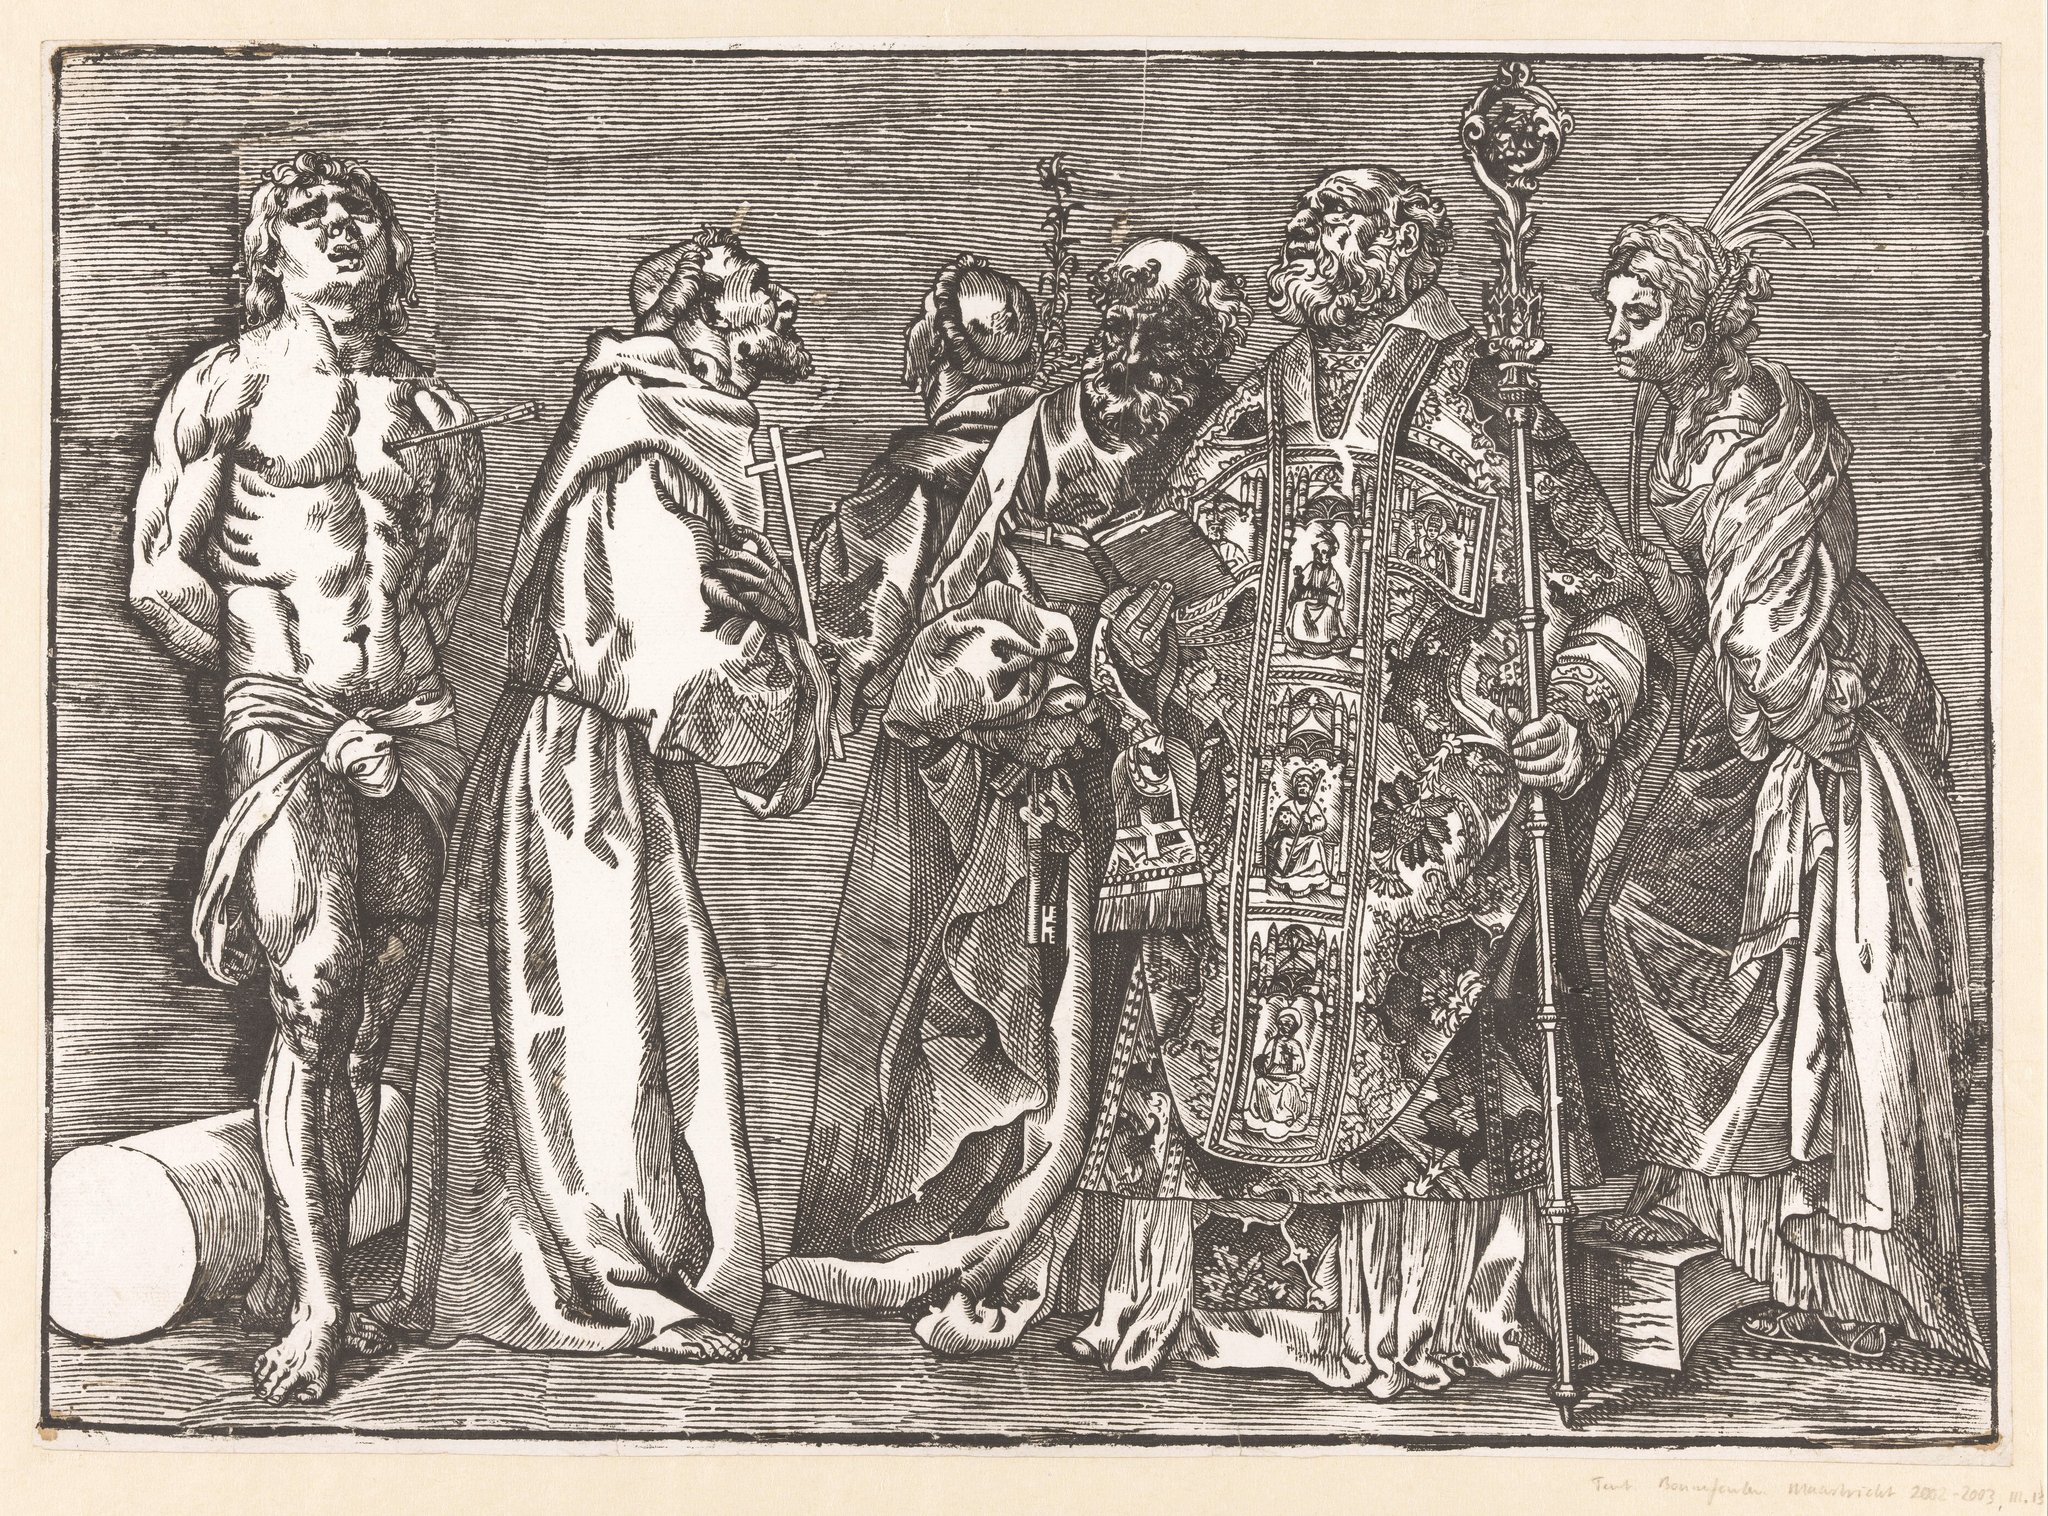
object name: print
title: Zes staande heiligen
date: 1535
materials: paper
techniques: woodcut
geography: venice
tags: the virgin martyr catherine of alexandria; possible attributes: book, crown, emperor maxentius, palm-branch, ring, sword, wheel, the bishop nicholas of myra (or bari); possible attributes: anchor, boat, three golden balls (on a book), three purses, three children in a tub, three maidens, the martyr sebastian; possible attributes: arrow(s), bow, tree-trunk, founder of the order of friars minor (franciscans), francis(cus) of assisi; possible attributes: book, crucifix, lily, skull, stigmata, the apostle peter, first bishop of rome; possible attributes: book, cock, (upturned) cross, (triple) crozier, fish, key, scroll, ship, tiara, the franciscan monk antony of padua; possible attributes: ass, book, crucifix, flowered cross, flaming heart, infant christ (on book), lily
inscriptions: collector's mark: Lugt 2228, collector's mark: Lugt 240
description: Zes heiligen, staand naast elkaar: Sebastiaan met pijl in zijn borst, Franciscus met kruis, Antonius met lelie, Petrus met sleutel, Nicolaas van Myra met boek en kromstaf en Catharina met een stuk van het rad en een palmtak van het martelaarschap.